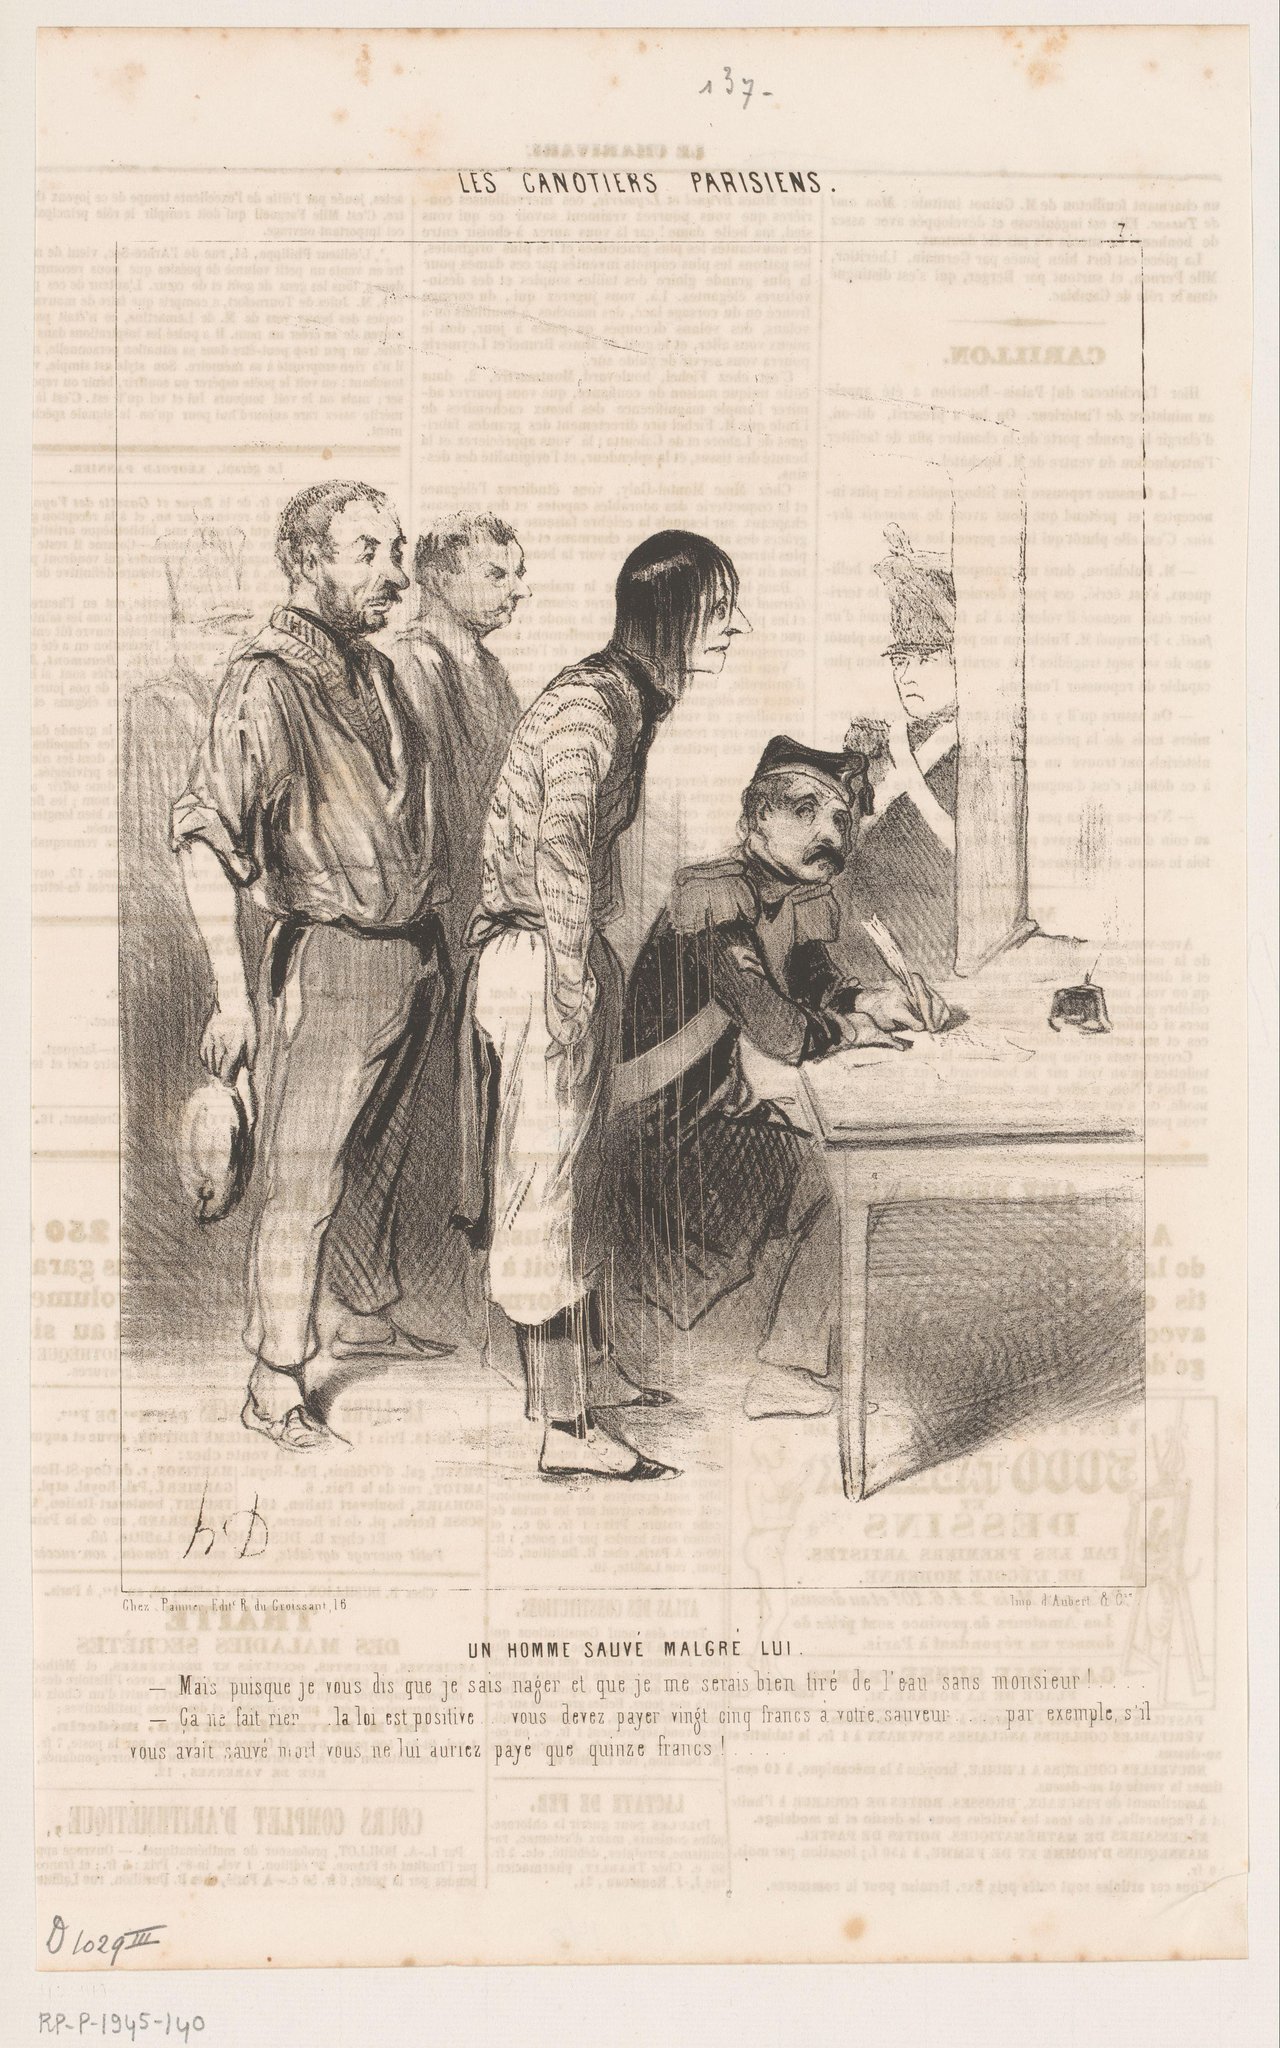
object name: cartoon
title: Karikatuur van een geredde drenkeling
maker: honoré daumier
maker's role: draughtsman, painter, print maker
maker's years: 1808-1879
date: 1843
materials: paper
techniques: lithograph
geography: paris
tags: caricatures (human types), saving a person from drowning, paris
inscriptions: number: ‘137’, collector's mark: Lugt 2228a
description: Prent gepubliceerd in: Le Charivari, Aubert: Parijs, 16-05-1843. Le Charivari was een humoristische krant met karikaturen en (politieke) cartoons.